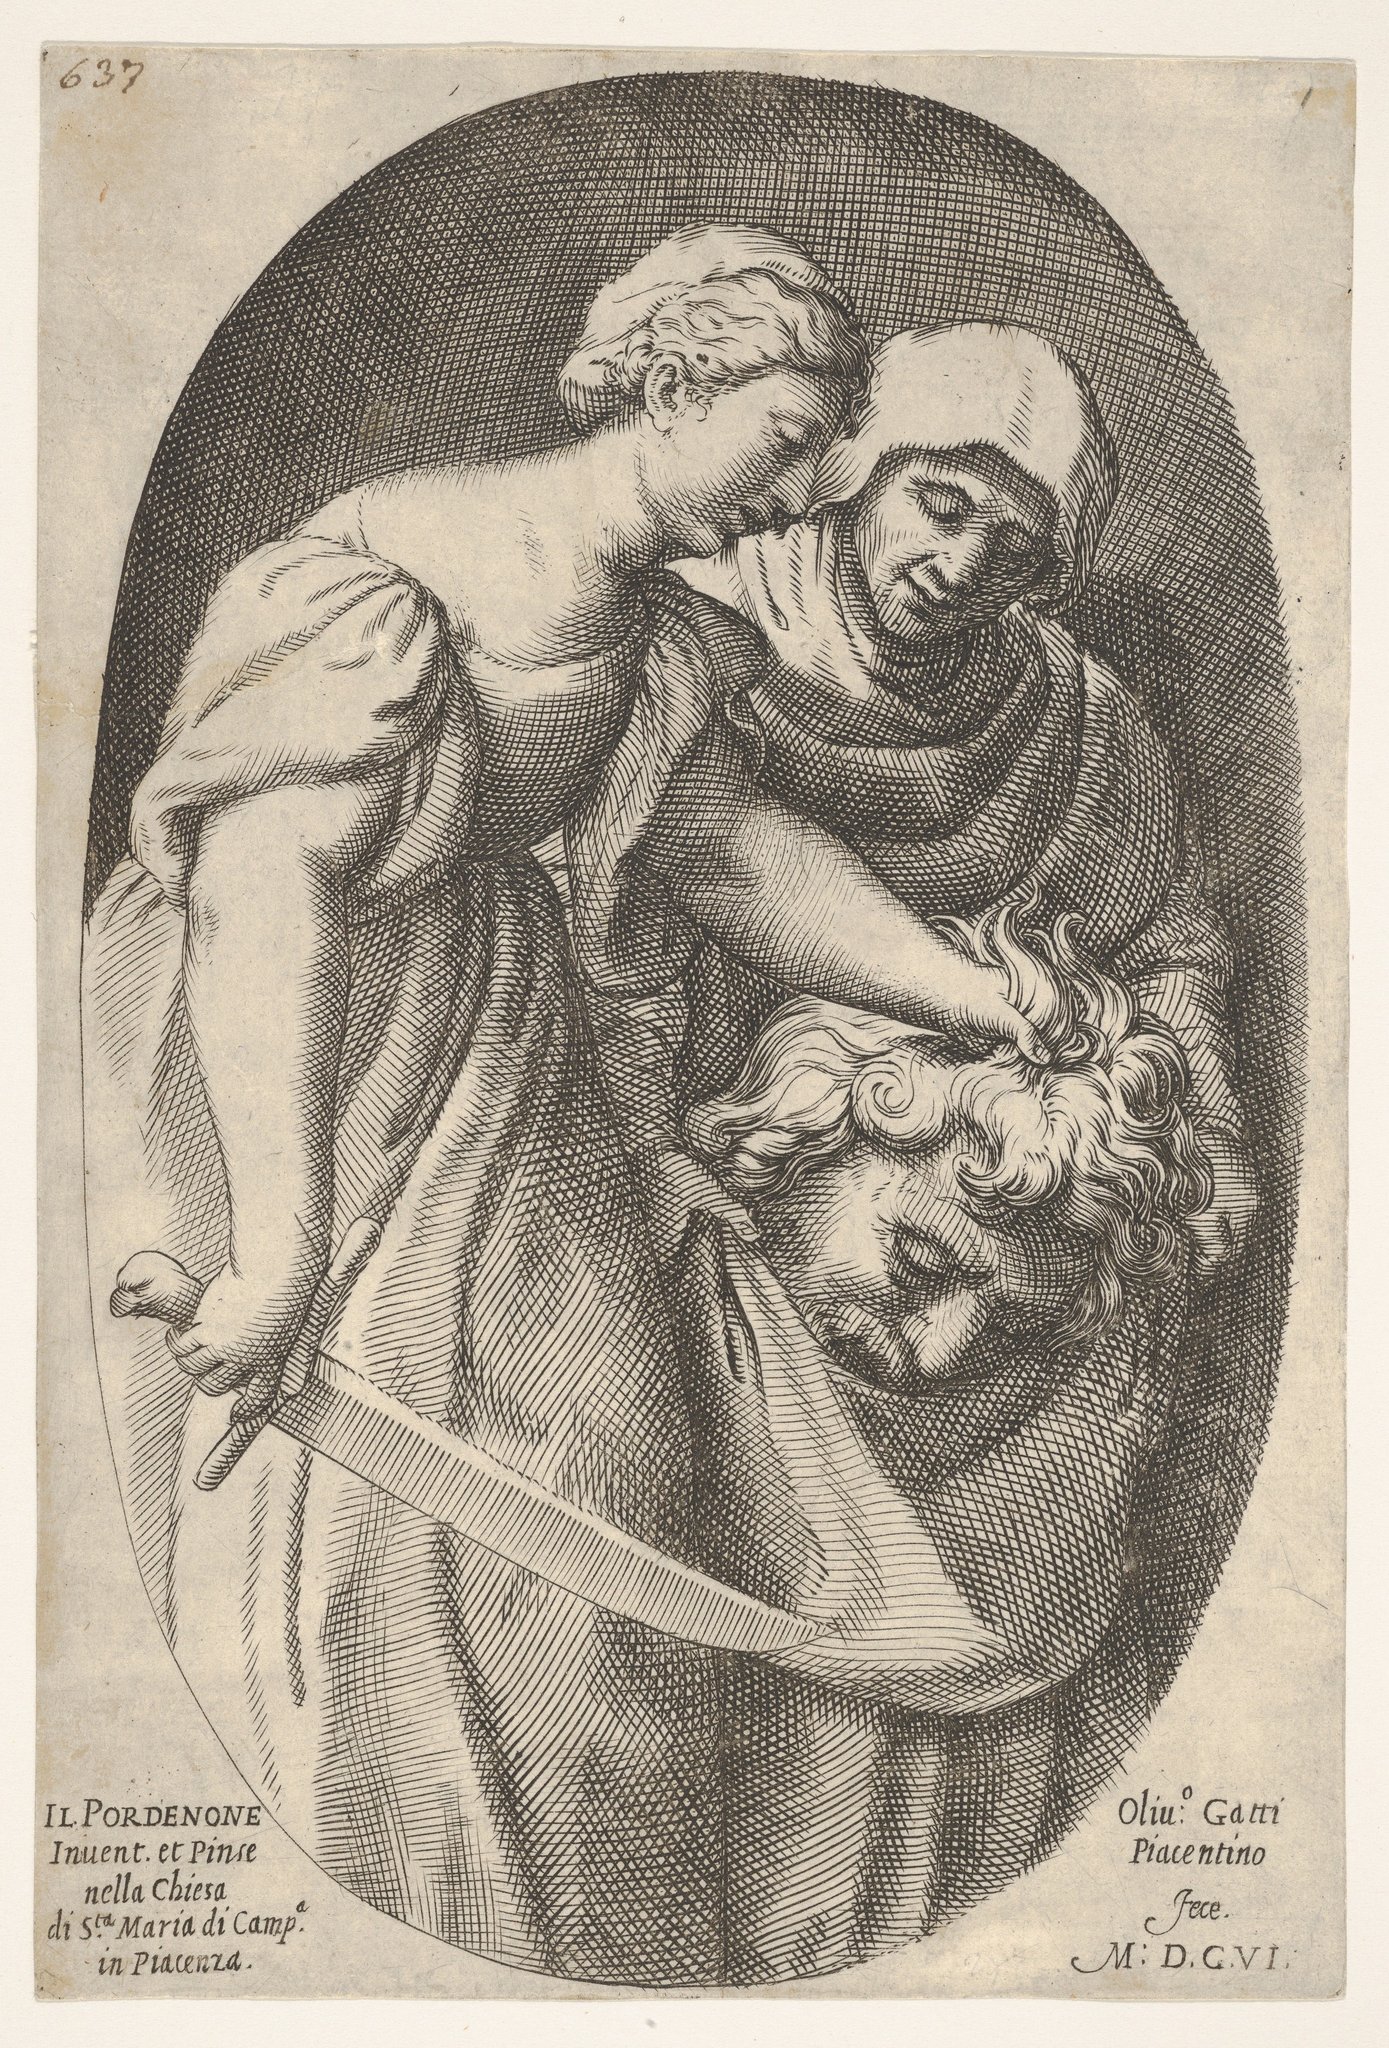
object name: print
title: Judith with the head of Holofernes in her left hand and a sword in her right hand, accompanied by a female attendant, from a series of four Old Testament subjects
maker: oliviero gatti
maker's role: artist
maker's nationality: italian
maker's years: 1610-1630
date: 1606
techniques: engraving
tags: swords,heads,women,holofernes,judith